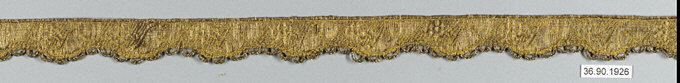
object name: galloon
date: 1767-1833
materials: metal thread, silk